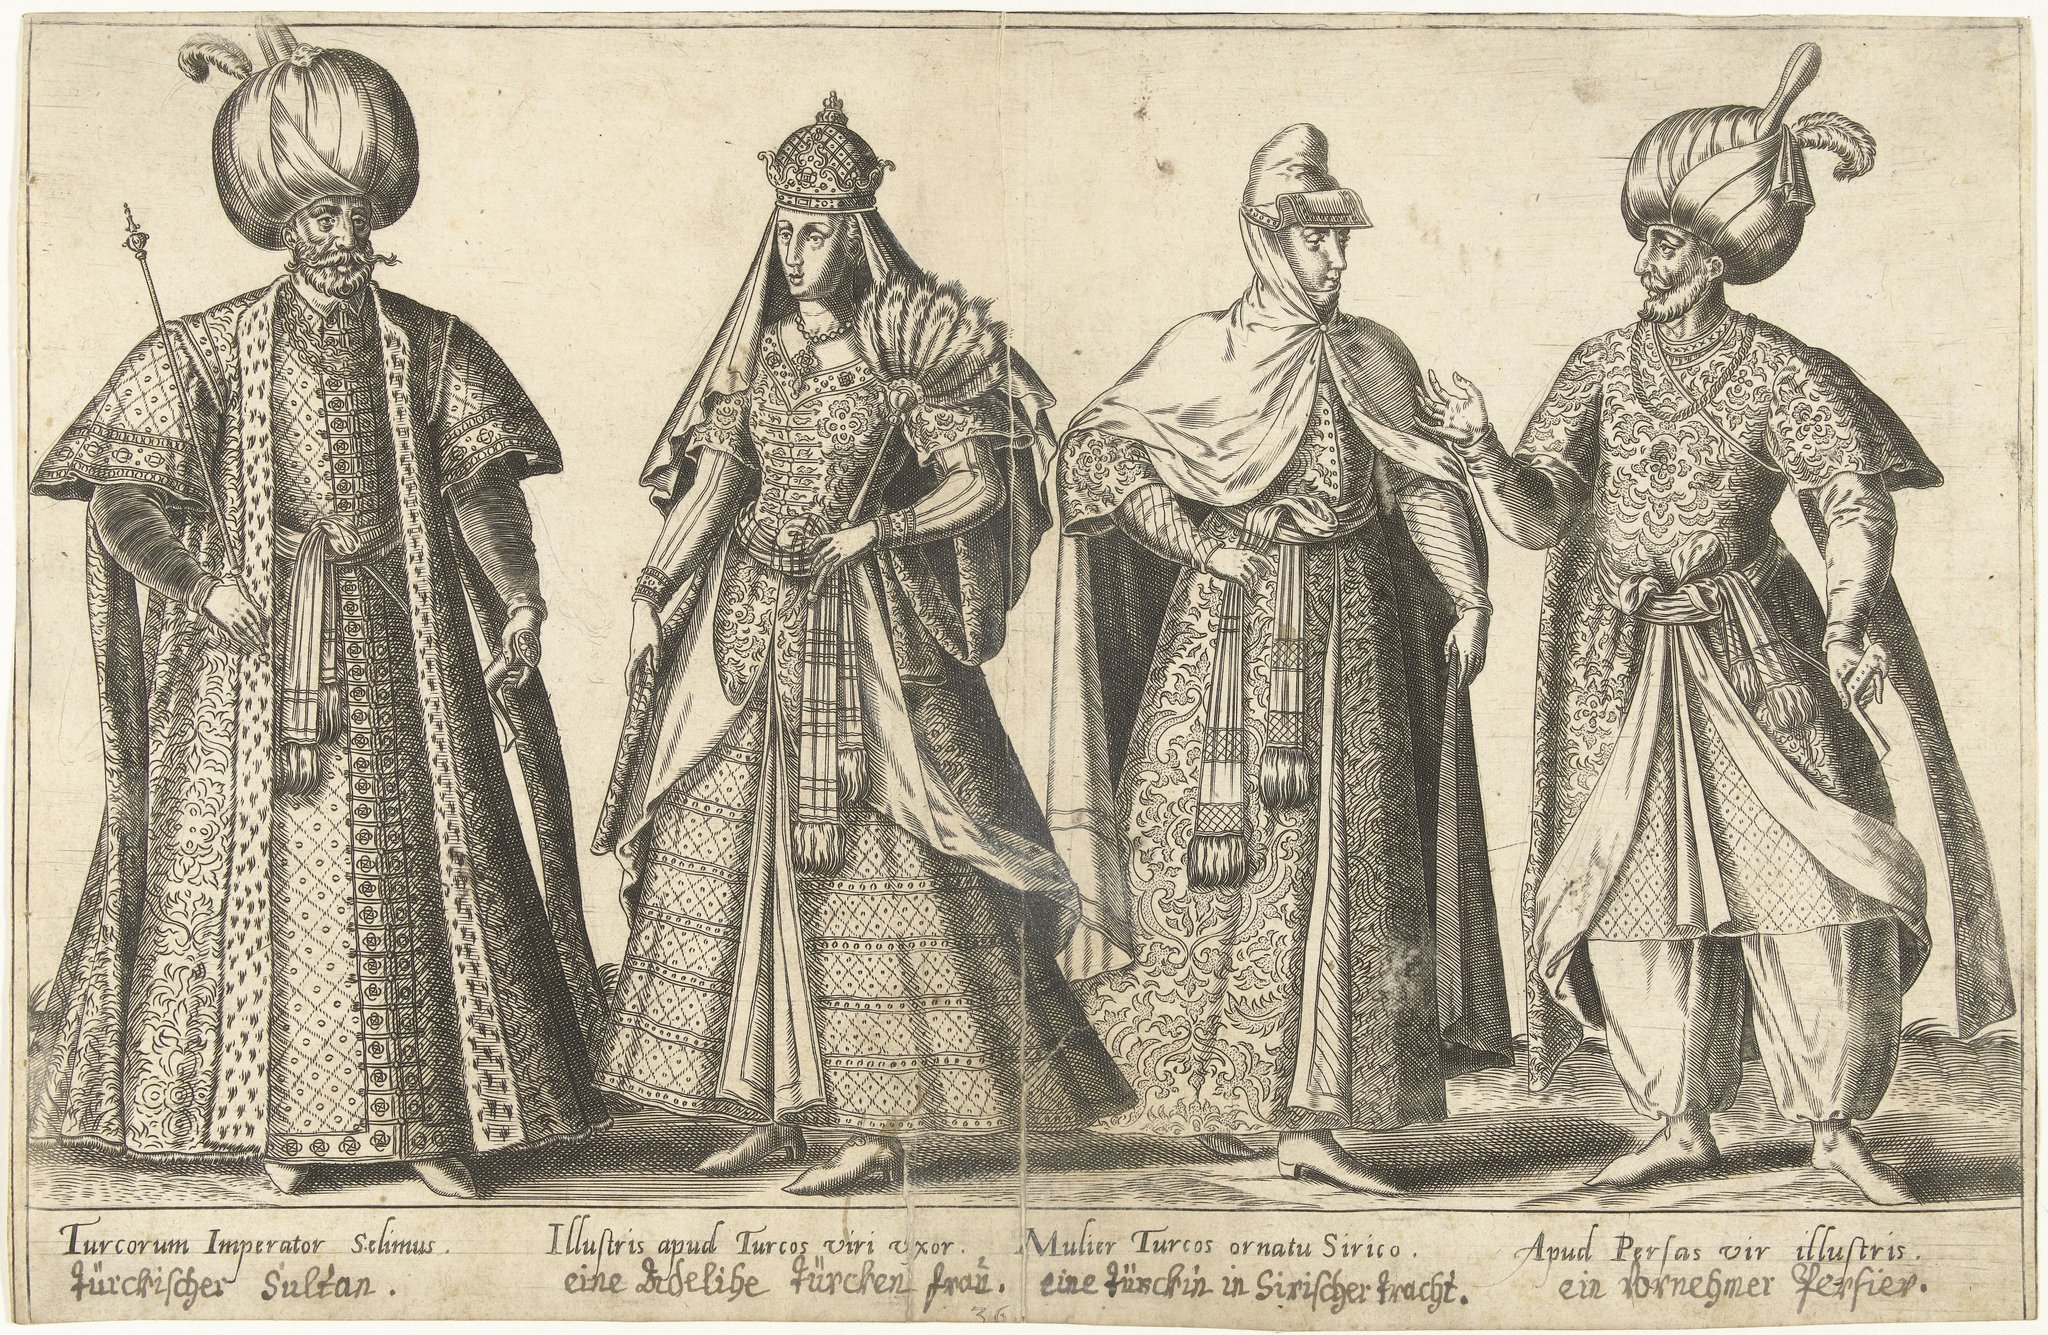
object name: costume print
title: Traditionele kleding van over de hele wereld rond 1580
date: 1581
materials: paper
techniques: engraving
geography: antwerp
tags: asiatic races and peoples: turks, clothes, costume (+ women's clothes), clothes, costume (+ men's clothes), dignitary at court - bb - female dignitary: lady-in-waiting, asiatic races and peoples: persians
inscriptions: caption: ‘Türckische Sultan. eine Eidelihe Türcken fraü. eine Türchin in Sirischer Tracht. Ein fornehmer Persier’, collector's mark: Lugt 2228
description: Prent uit een boek over zestiende-eeuwse kleding rond 1580. Vier leden van het Ottomaanse hof, twee mannen en twee vrouwen. Alle vier zijn anders gekleed. Van links naar rechts: sultan Selim I, een belangrijke Ottomaanse hofdame, een vrouw in Syrische kleding en een voorname Perzische man. De prent heeft een Latijns onderschrift.